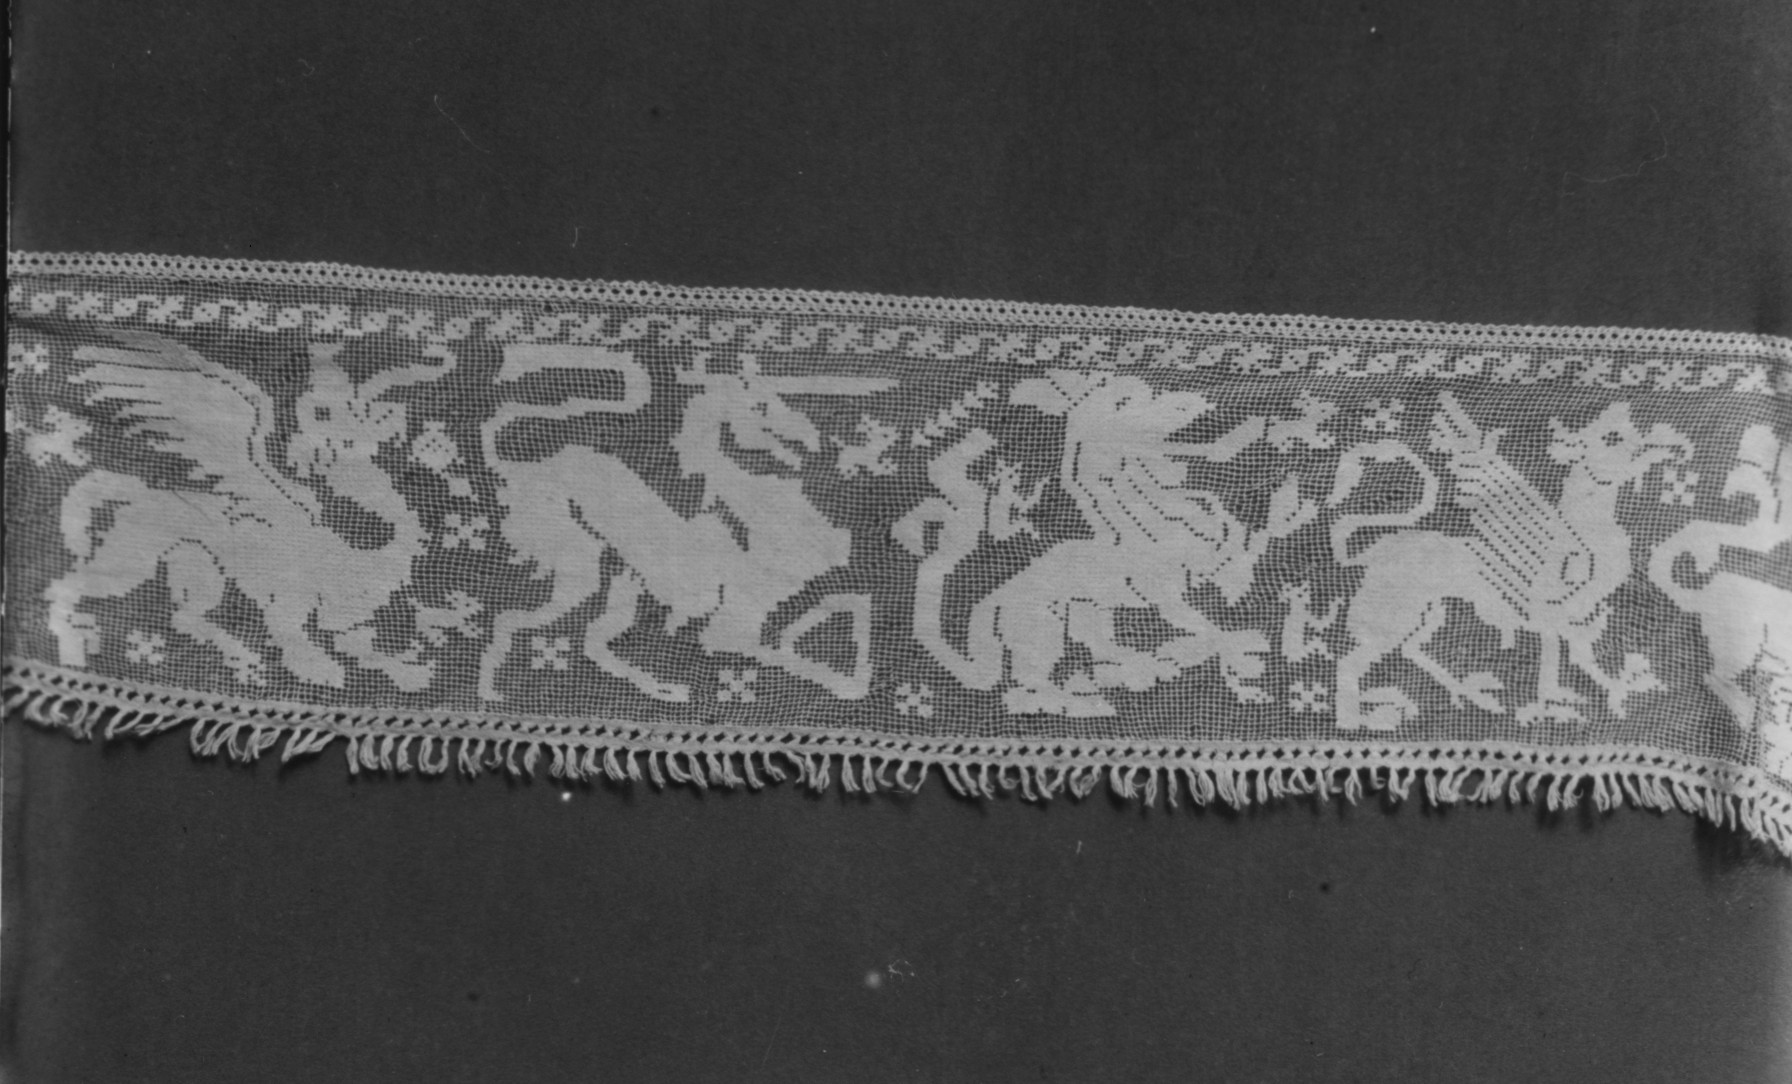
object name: border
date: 1401-1600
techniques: embroidery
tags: mythical creatures,lions